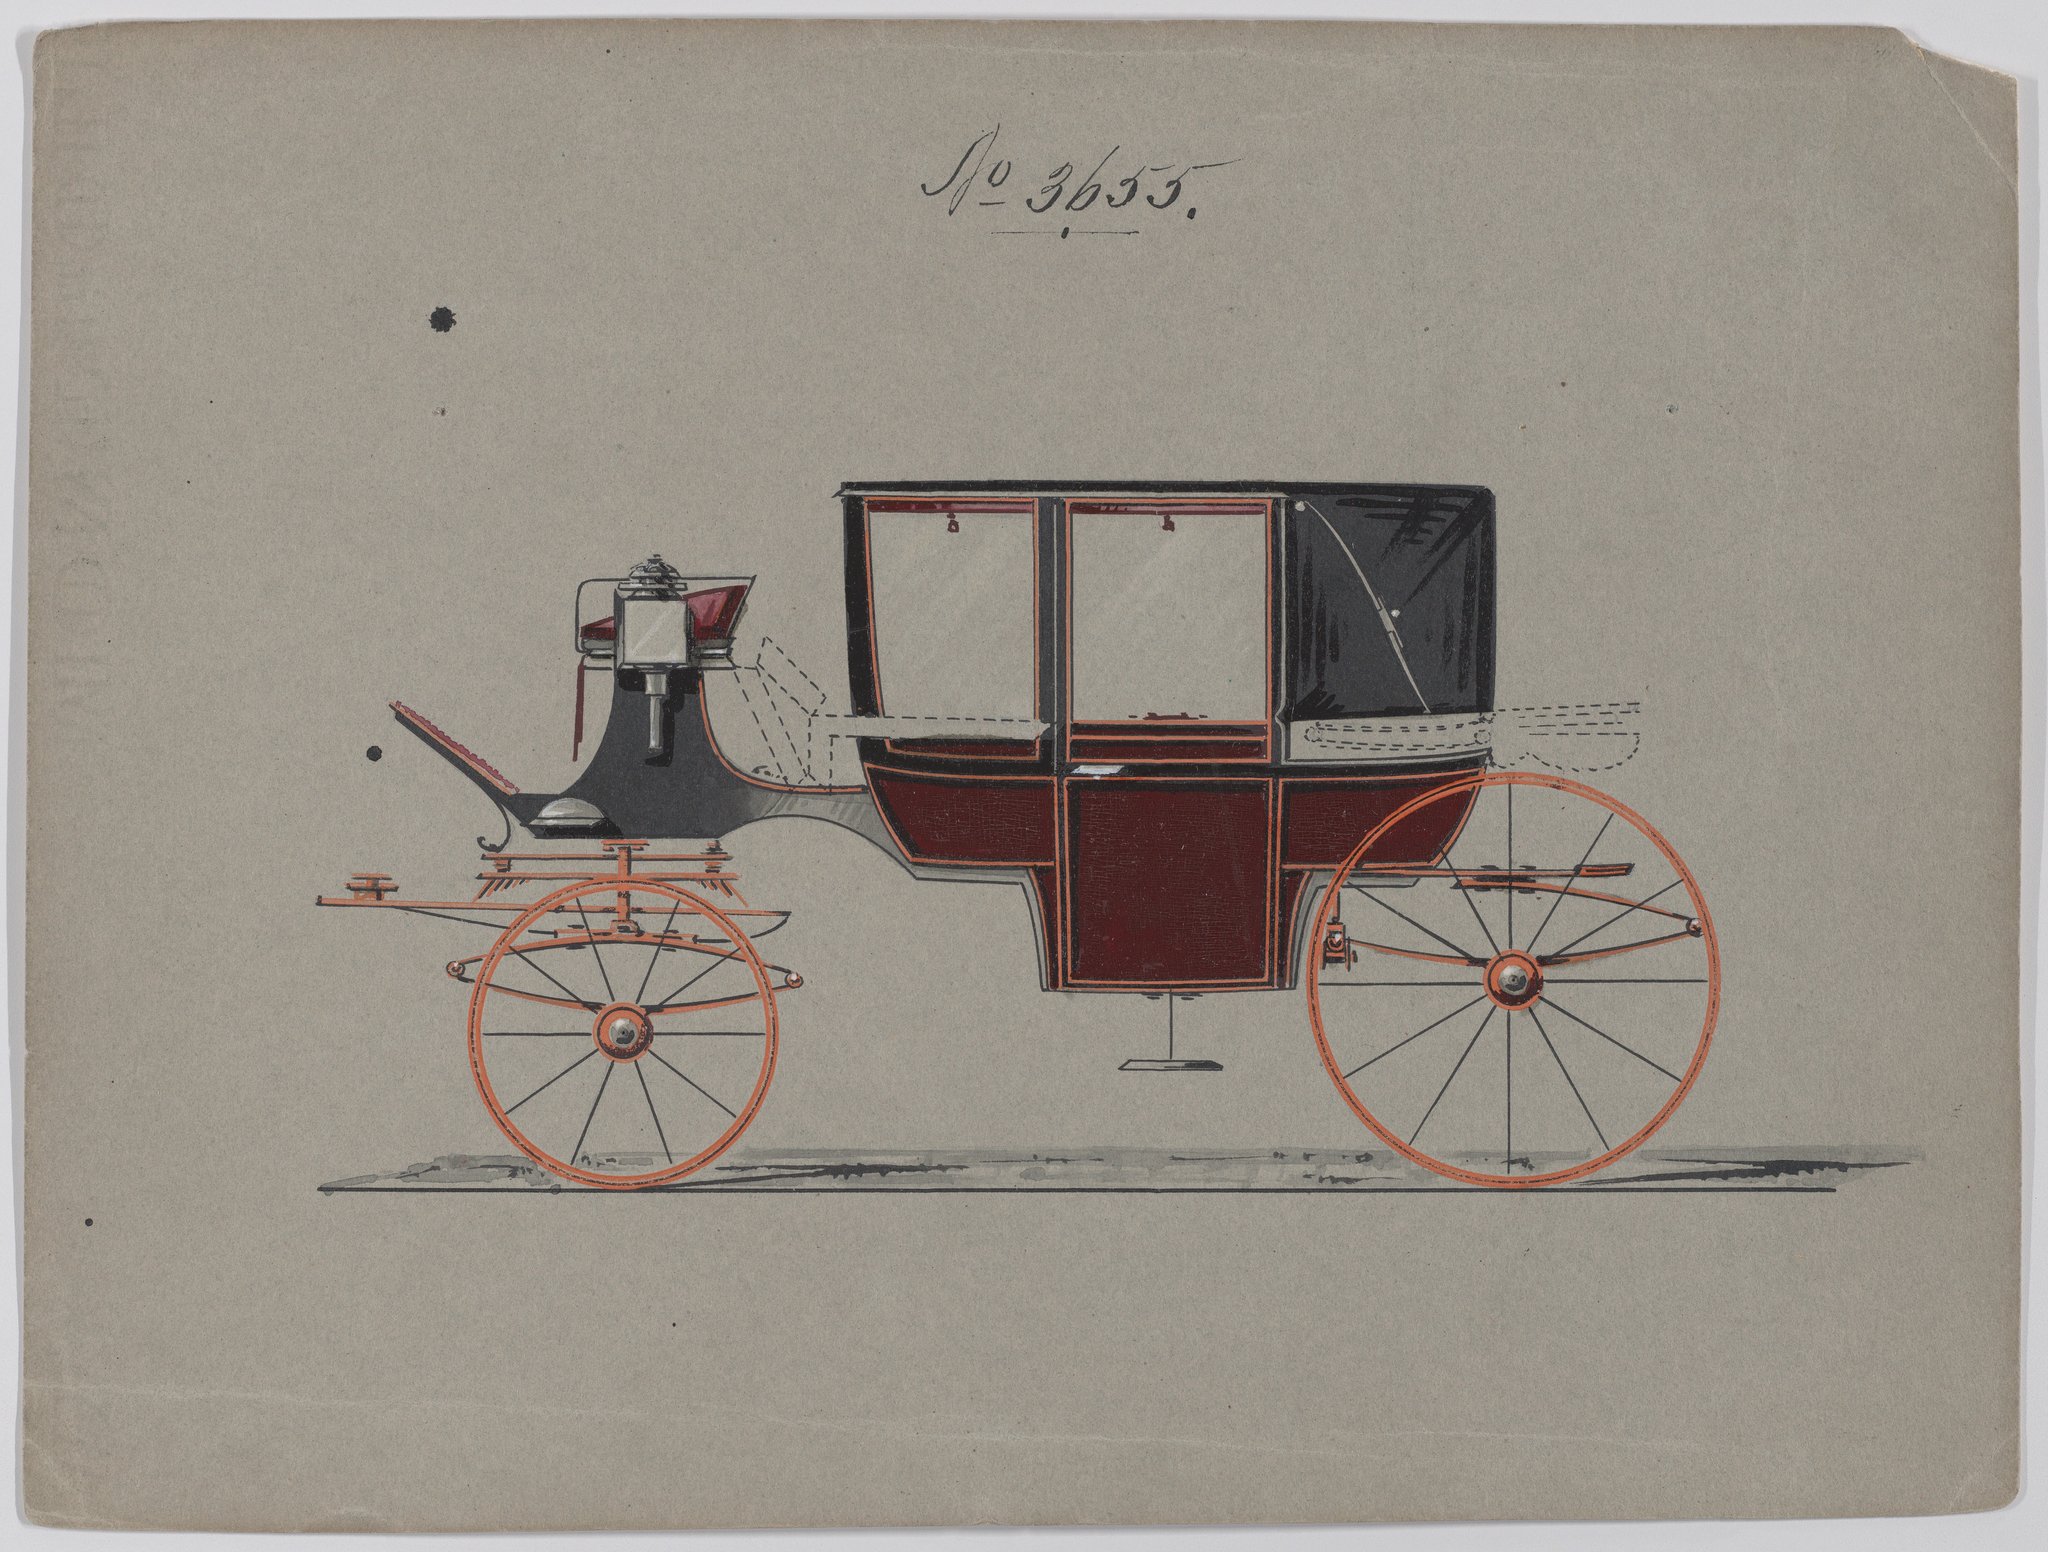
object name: drawing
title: Design for Landau, No. 3655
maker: brewster & co.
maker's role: manufacturer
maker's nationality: american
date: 1881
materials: gouache, gum arabic, ink, watercolor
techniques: pen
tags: carriages